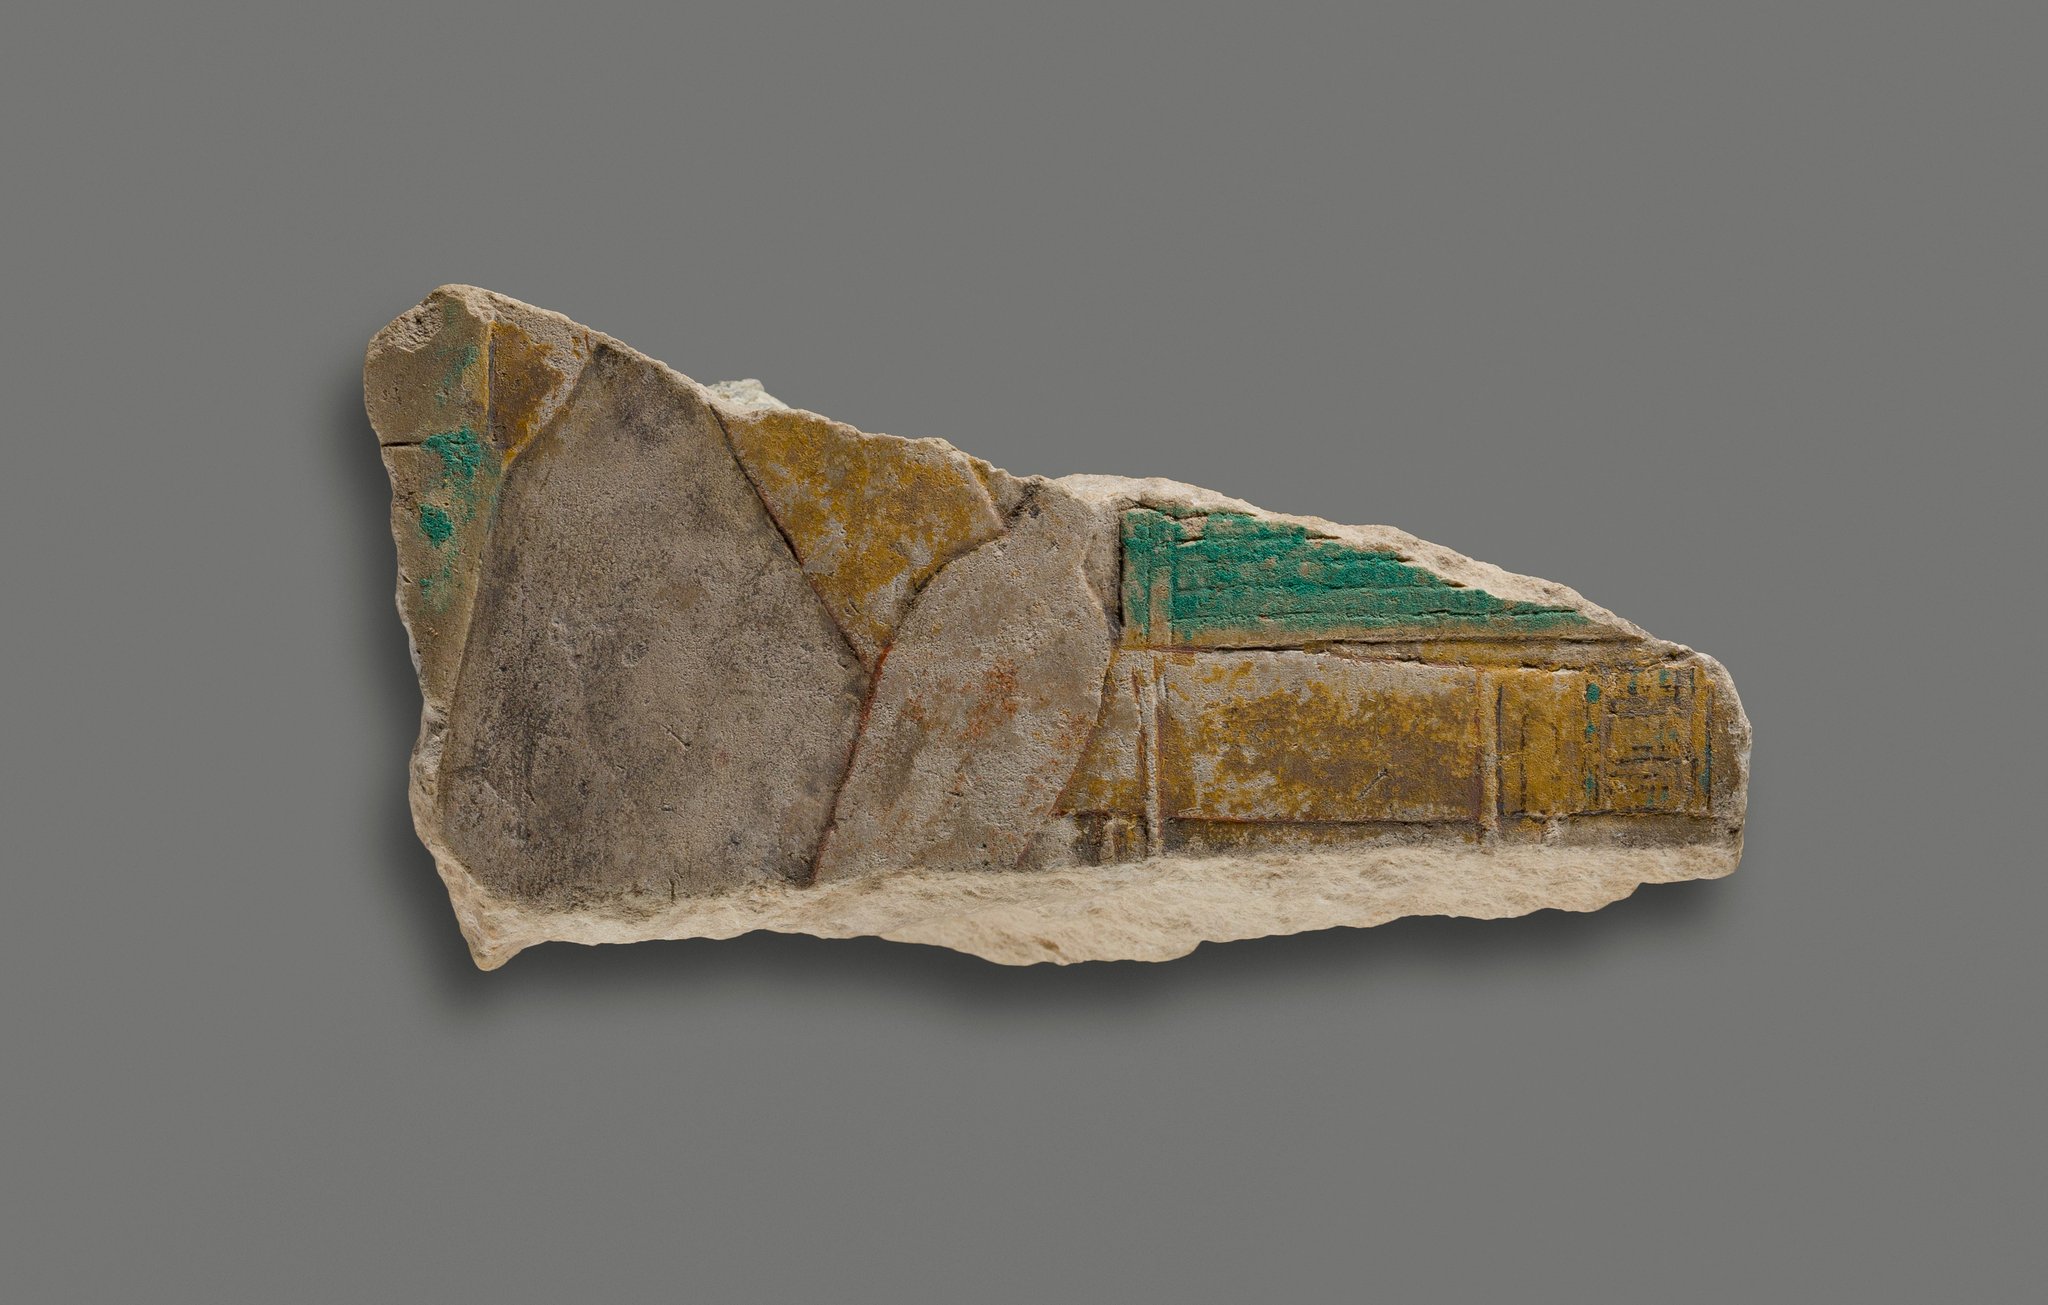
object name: relief fragment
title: Fragment of relief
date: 1981-1640 BCE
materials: limestone, paint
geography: egypt